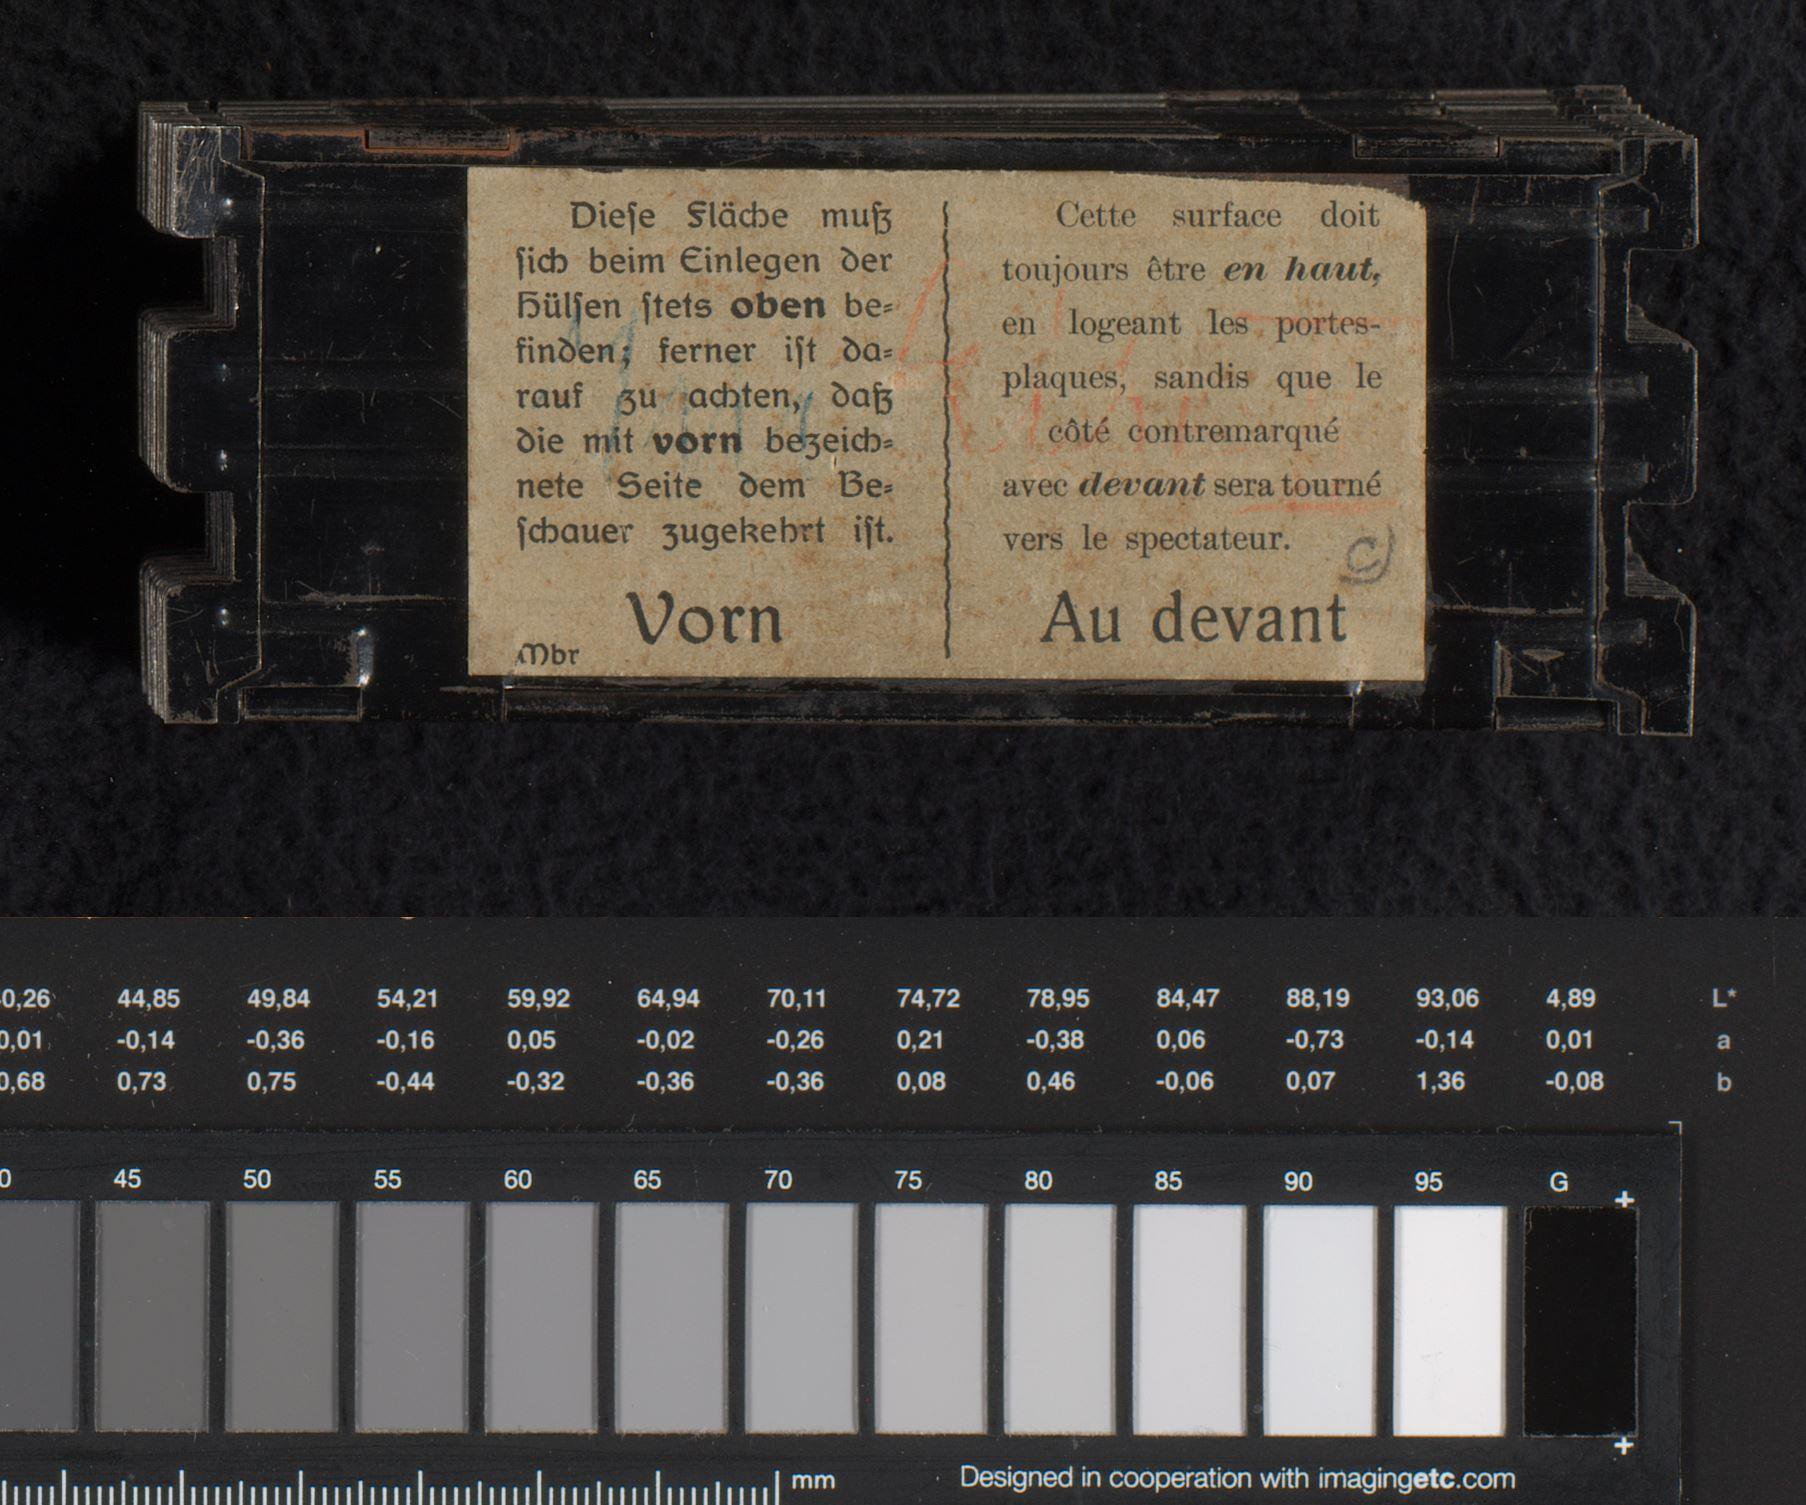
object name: accordion book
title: Leporelloalbum met twaalf stereoglasdia's van diverse plaatsen in Zuid-Frankrijk en Zwitserland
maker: Anonymous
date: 1920-1925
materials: glass, metal, paper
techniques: slide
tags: landscapes in the temperate zone, france, switzerland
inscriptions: inscription: ‘Diese Fläche muß (...) schauer zugekehrt ist./ Cette surface doit (....) vers le spectateur./ Mbr/ Vorn/ Au devant.’